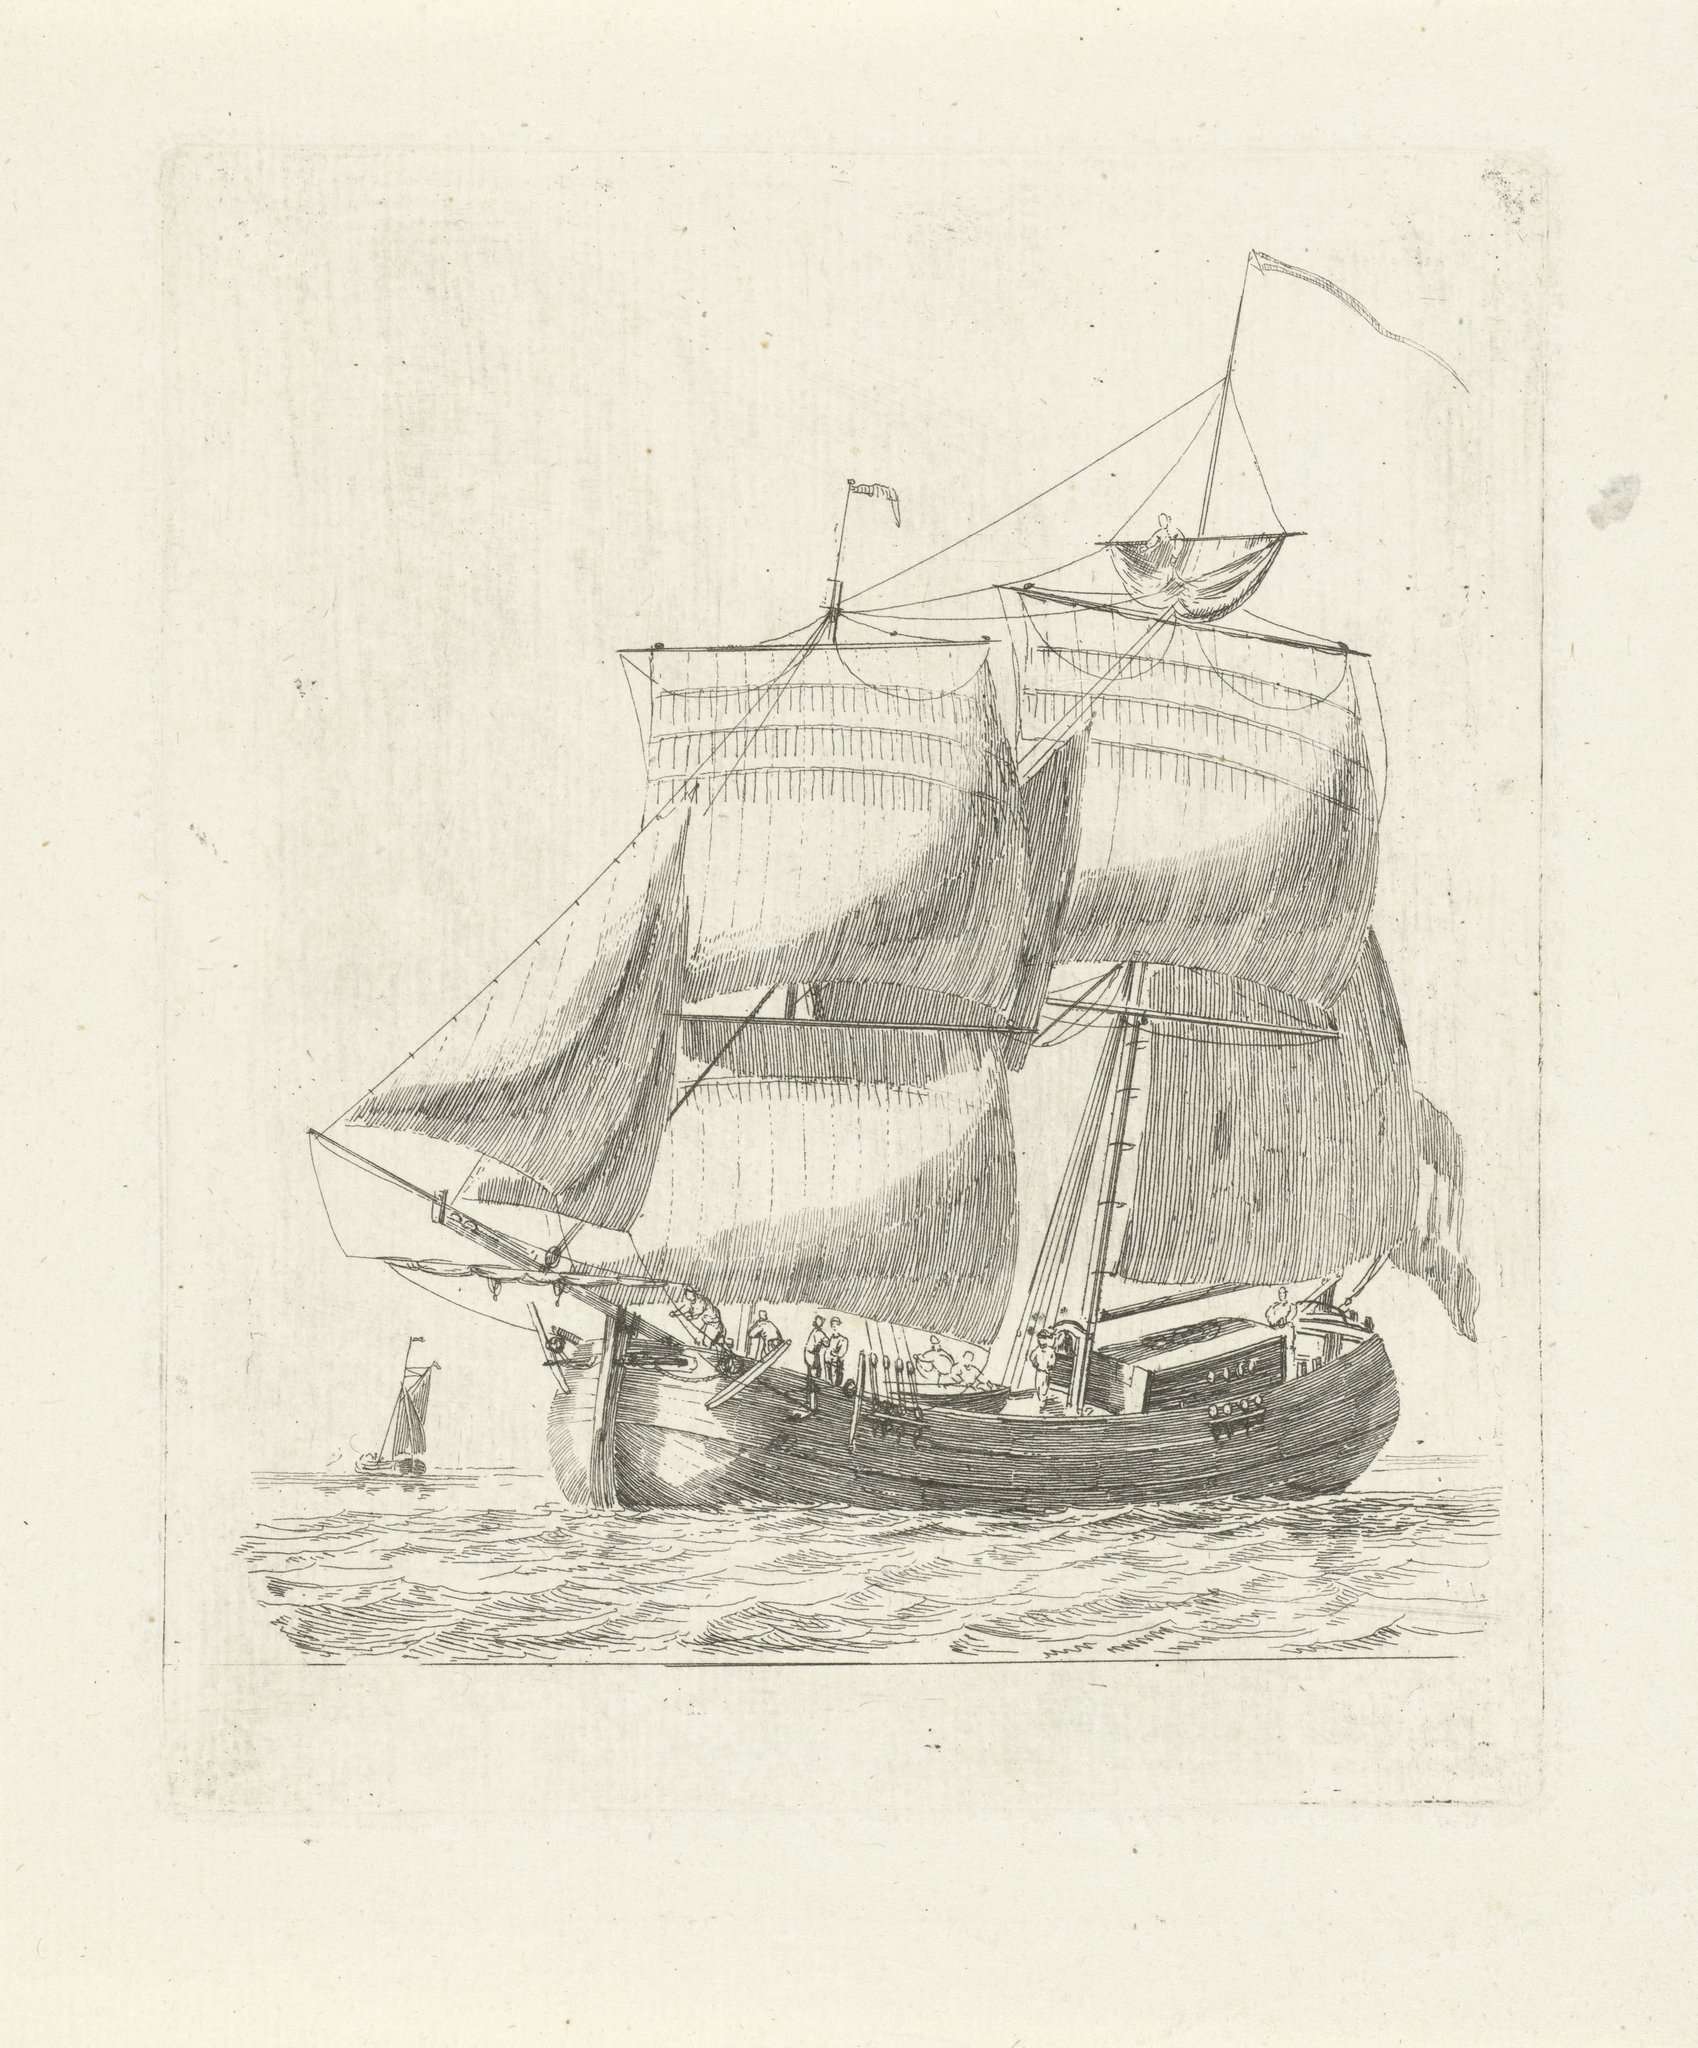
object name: print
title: Diverse boten serie B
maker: gerrit groenewegen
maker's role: draughtsman, print maker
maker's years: 1754-1826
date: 1787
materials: paper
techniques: etching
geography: rotterdam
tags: ships (in general)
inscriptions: collector's mark: Lugt 2228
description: Zeilschip op de golven met wind in de zeilen. Op de boot is een aantal figuren te zien, waarvan er een in de mast zit. Links op de achtergrond is een andere boot afgebeeld. Deze prent is deel van een serie van twaalf prenten met boten.